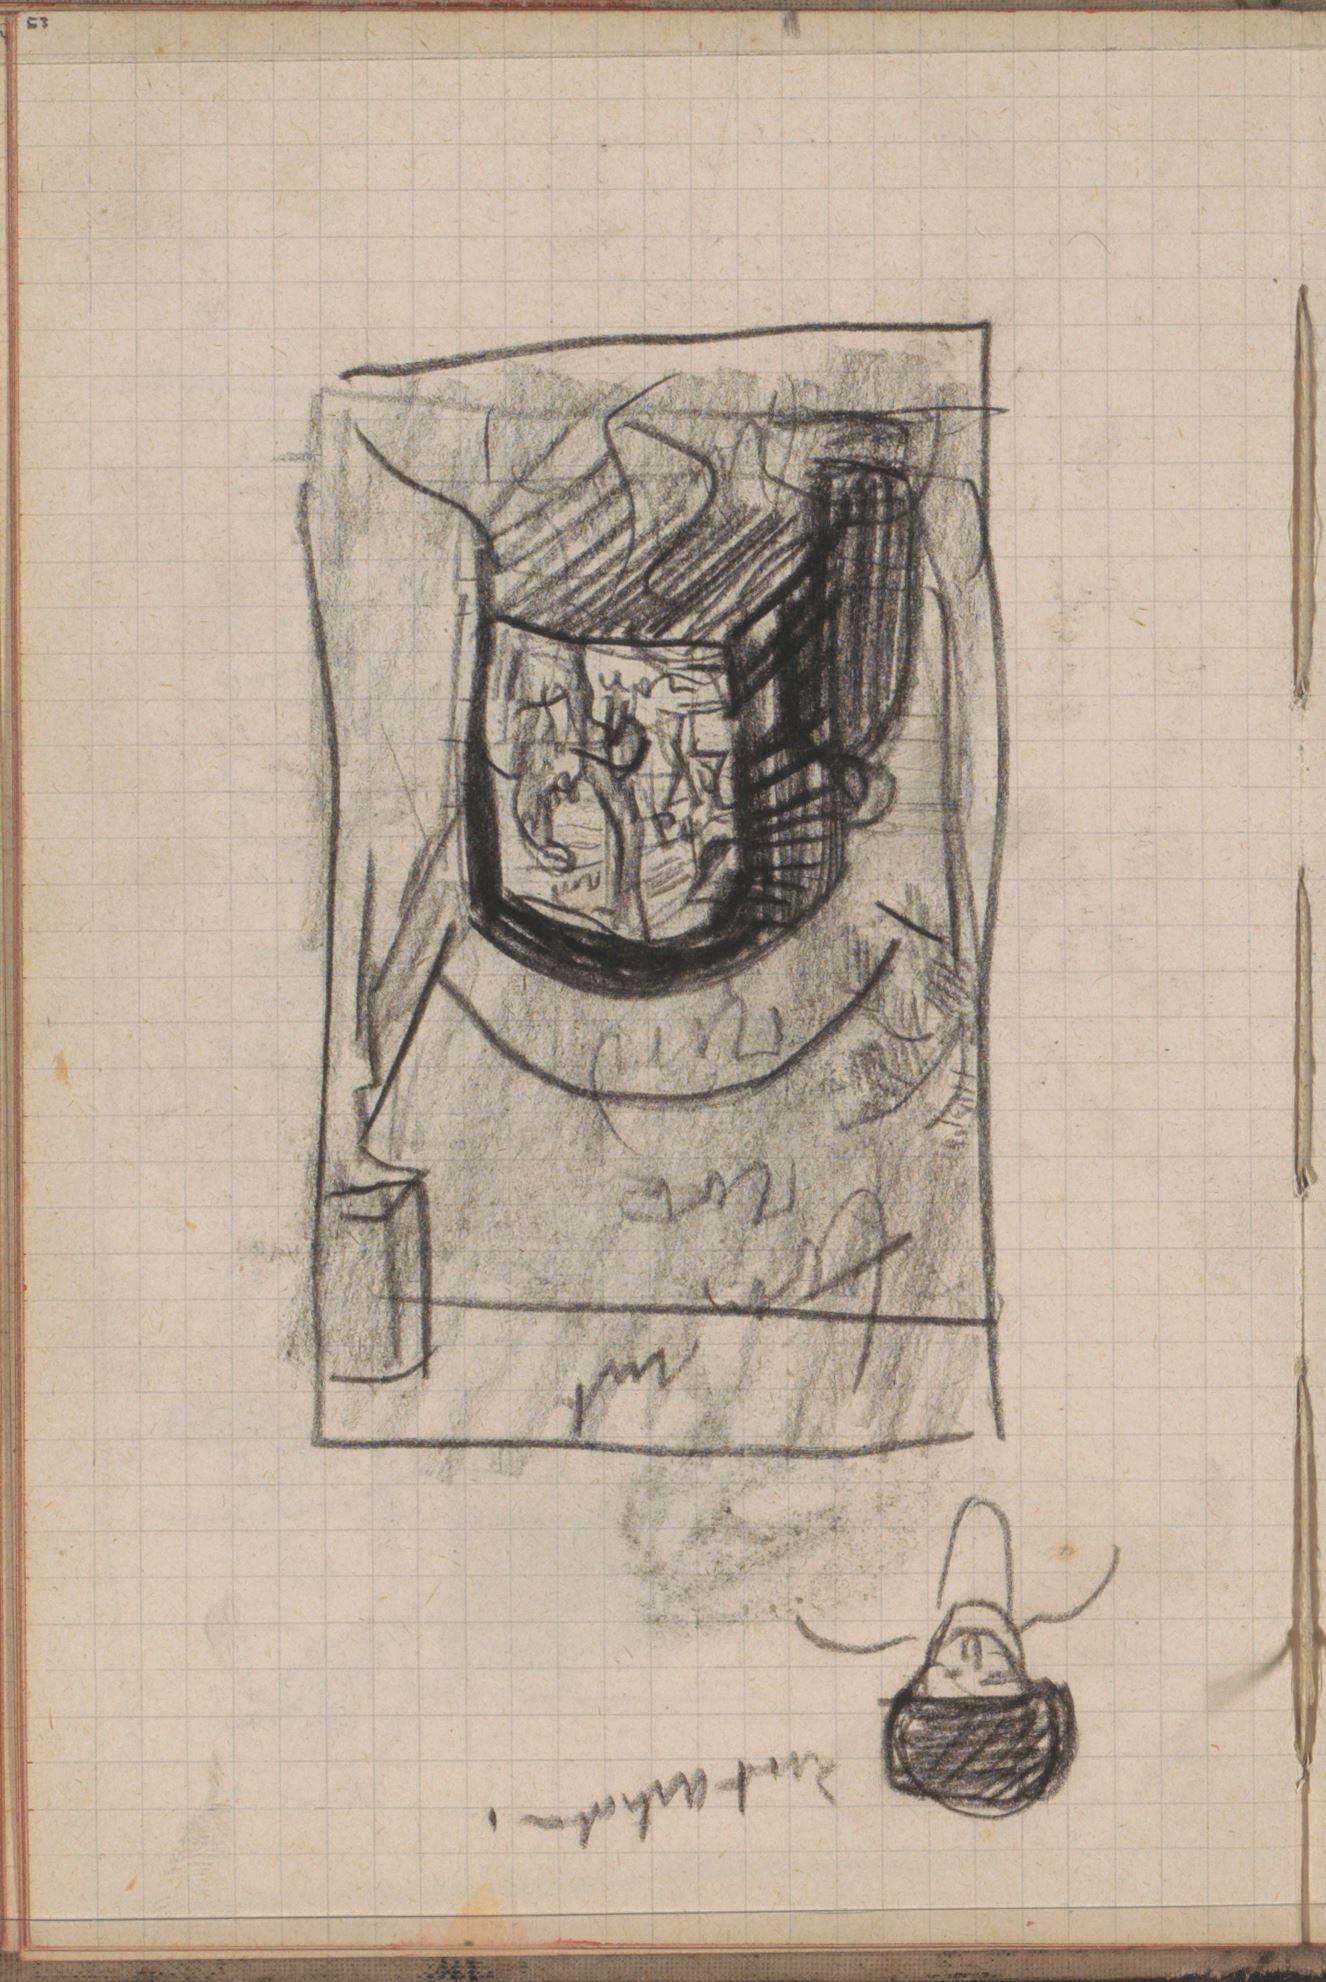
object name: sketchbook leaf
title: Studieblad, onder andere met een figuur te paard gezien door een portaal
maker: marius bauer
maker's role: draughtsman, print maker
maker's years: 1867-1932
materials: chalk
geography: istanbul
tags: riding a horse, ass, or mule; rider, horseman, head (human), arch, archivolt ~ architecture, street (+ city(-scape) with figures, staffage)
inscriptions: kleurnotitie, handgeschreven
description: Tevens een studie van een man met een oosters hoofddeksel. Pagina 53 uit een schetsboek met 54 bladen.